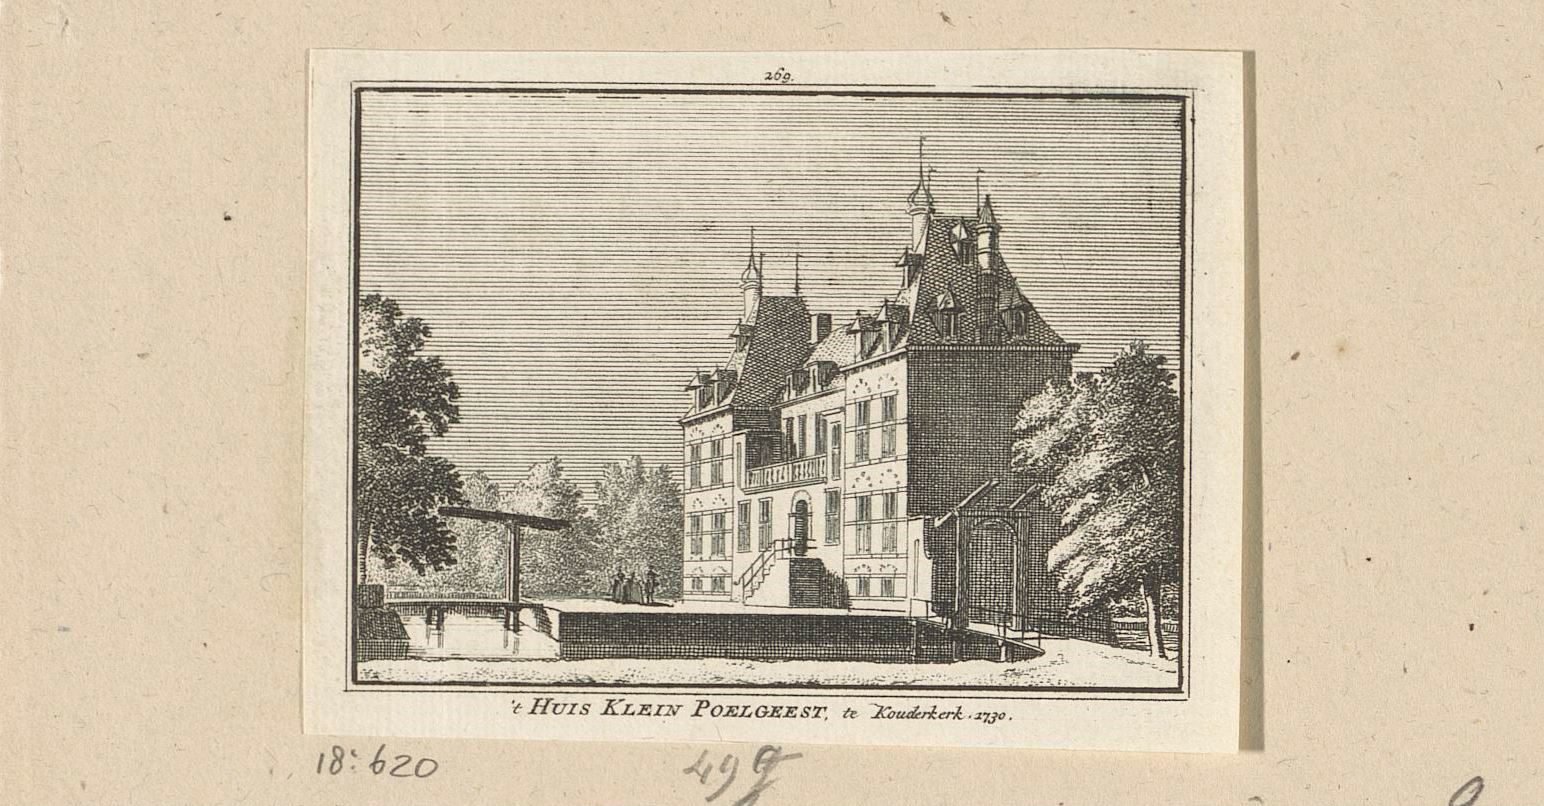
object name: book illustration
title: 't Huis Klein Poelgeest, te Kouderkerk. 1730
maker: hendrik spilman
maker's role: draughtsman, painter, print maker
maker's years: 1721-1784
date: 1750-1792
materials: paper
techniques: engraving, etching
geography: haarlem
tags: castle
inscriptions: collector's mark: Lugt 2228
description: Prent ook gebruikt in: Het verheerlykt Nederland of kabinet van hedendaagsche gezigten van steden, dorpen (…). 9 delen. Amsterdam: Isaak Tirion en weduwe Isaak Tirion, 1745-1774, dl. 3 (1750), ill. 269. Of in: Nederlandsche tafereelen; of eene keurige verzameling van negen honderd fraaije gezigten van steden, dorpen, sloten, oudheden (….). 9 delen. Amsterdam: Jan de Groot, 1792, dl. 3, ill. 269.